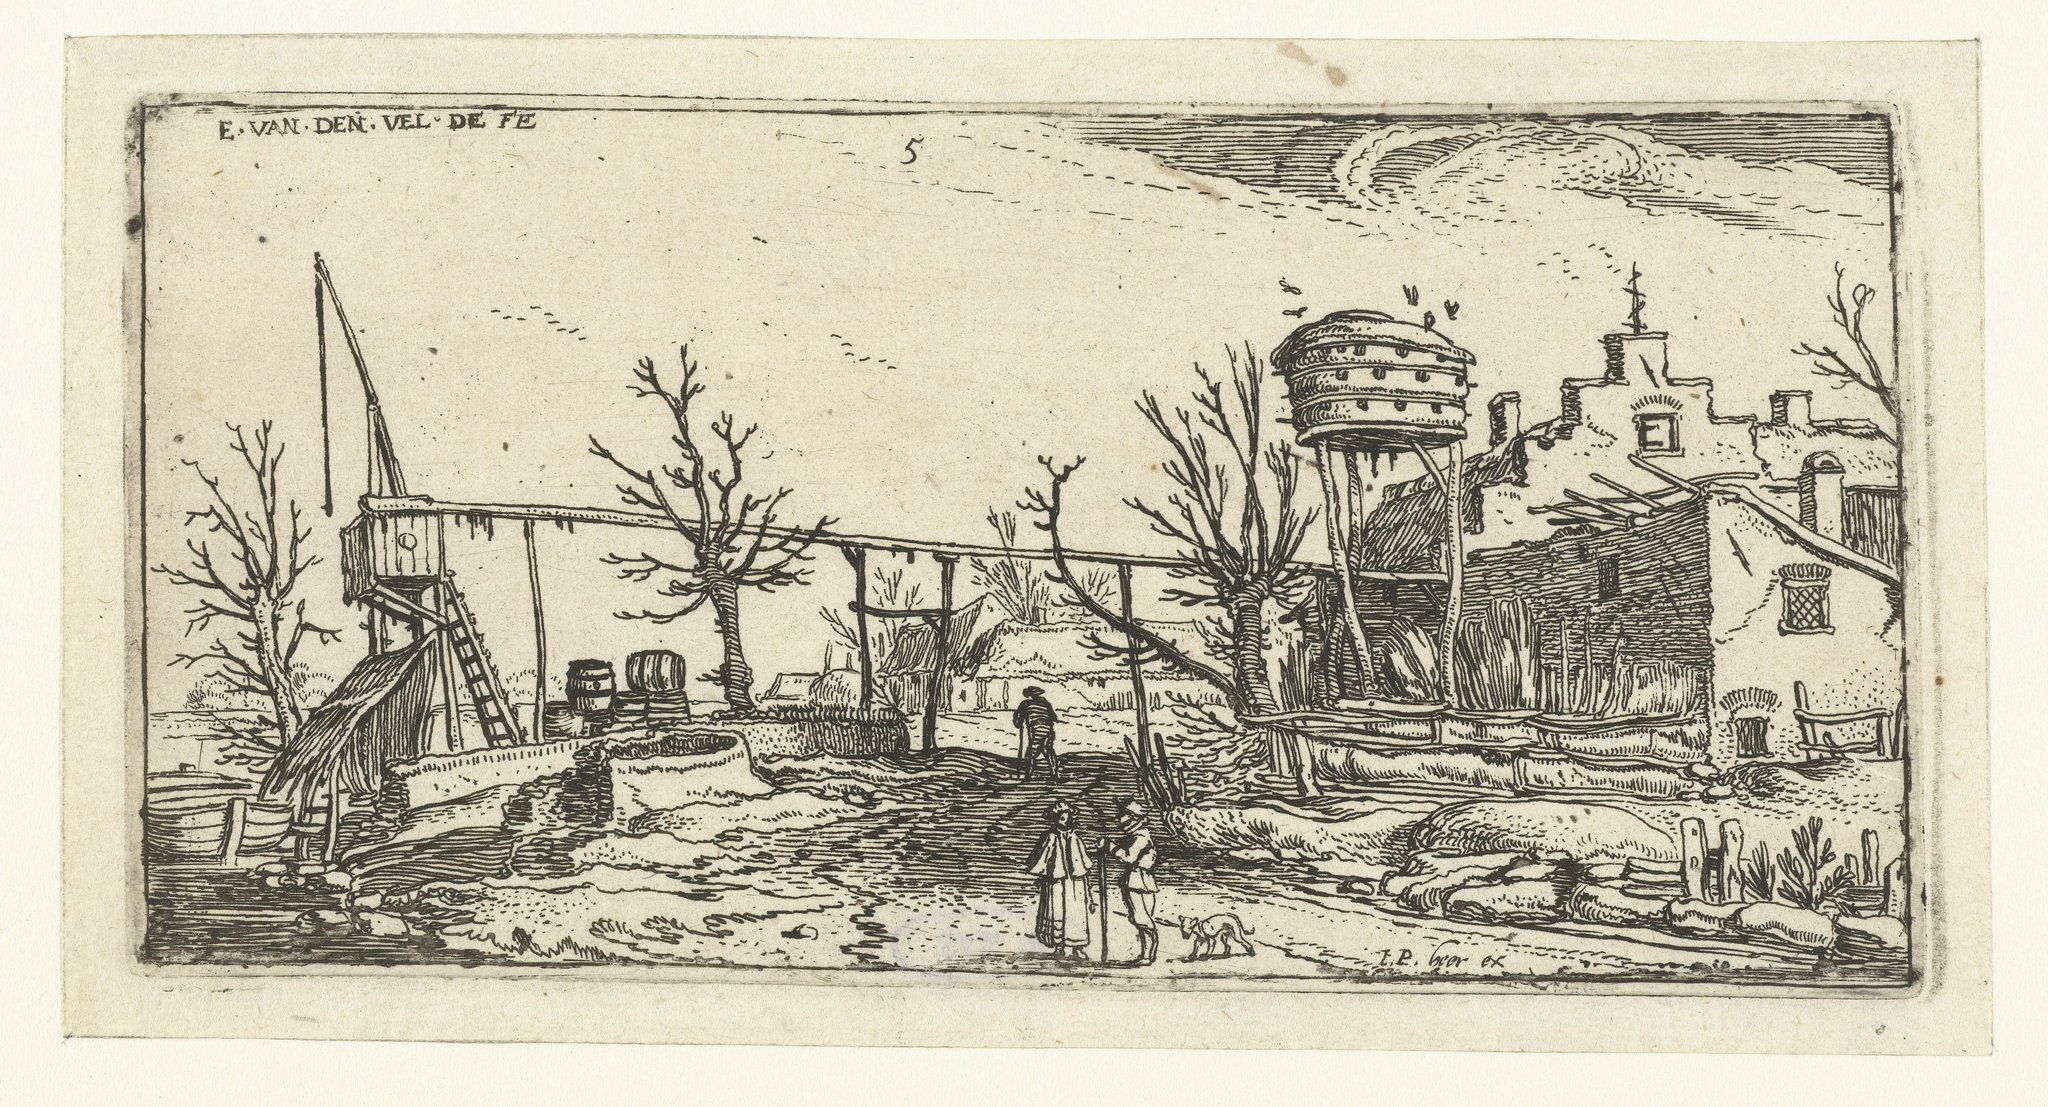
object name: print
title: Landschap met een brouwerij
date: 1615-1616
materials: paper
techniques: etching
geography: haarlem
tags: dove-cote, factories and mills in landscape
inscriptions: collector's mark: Lugt 2228a